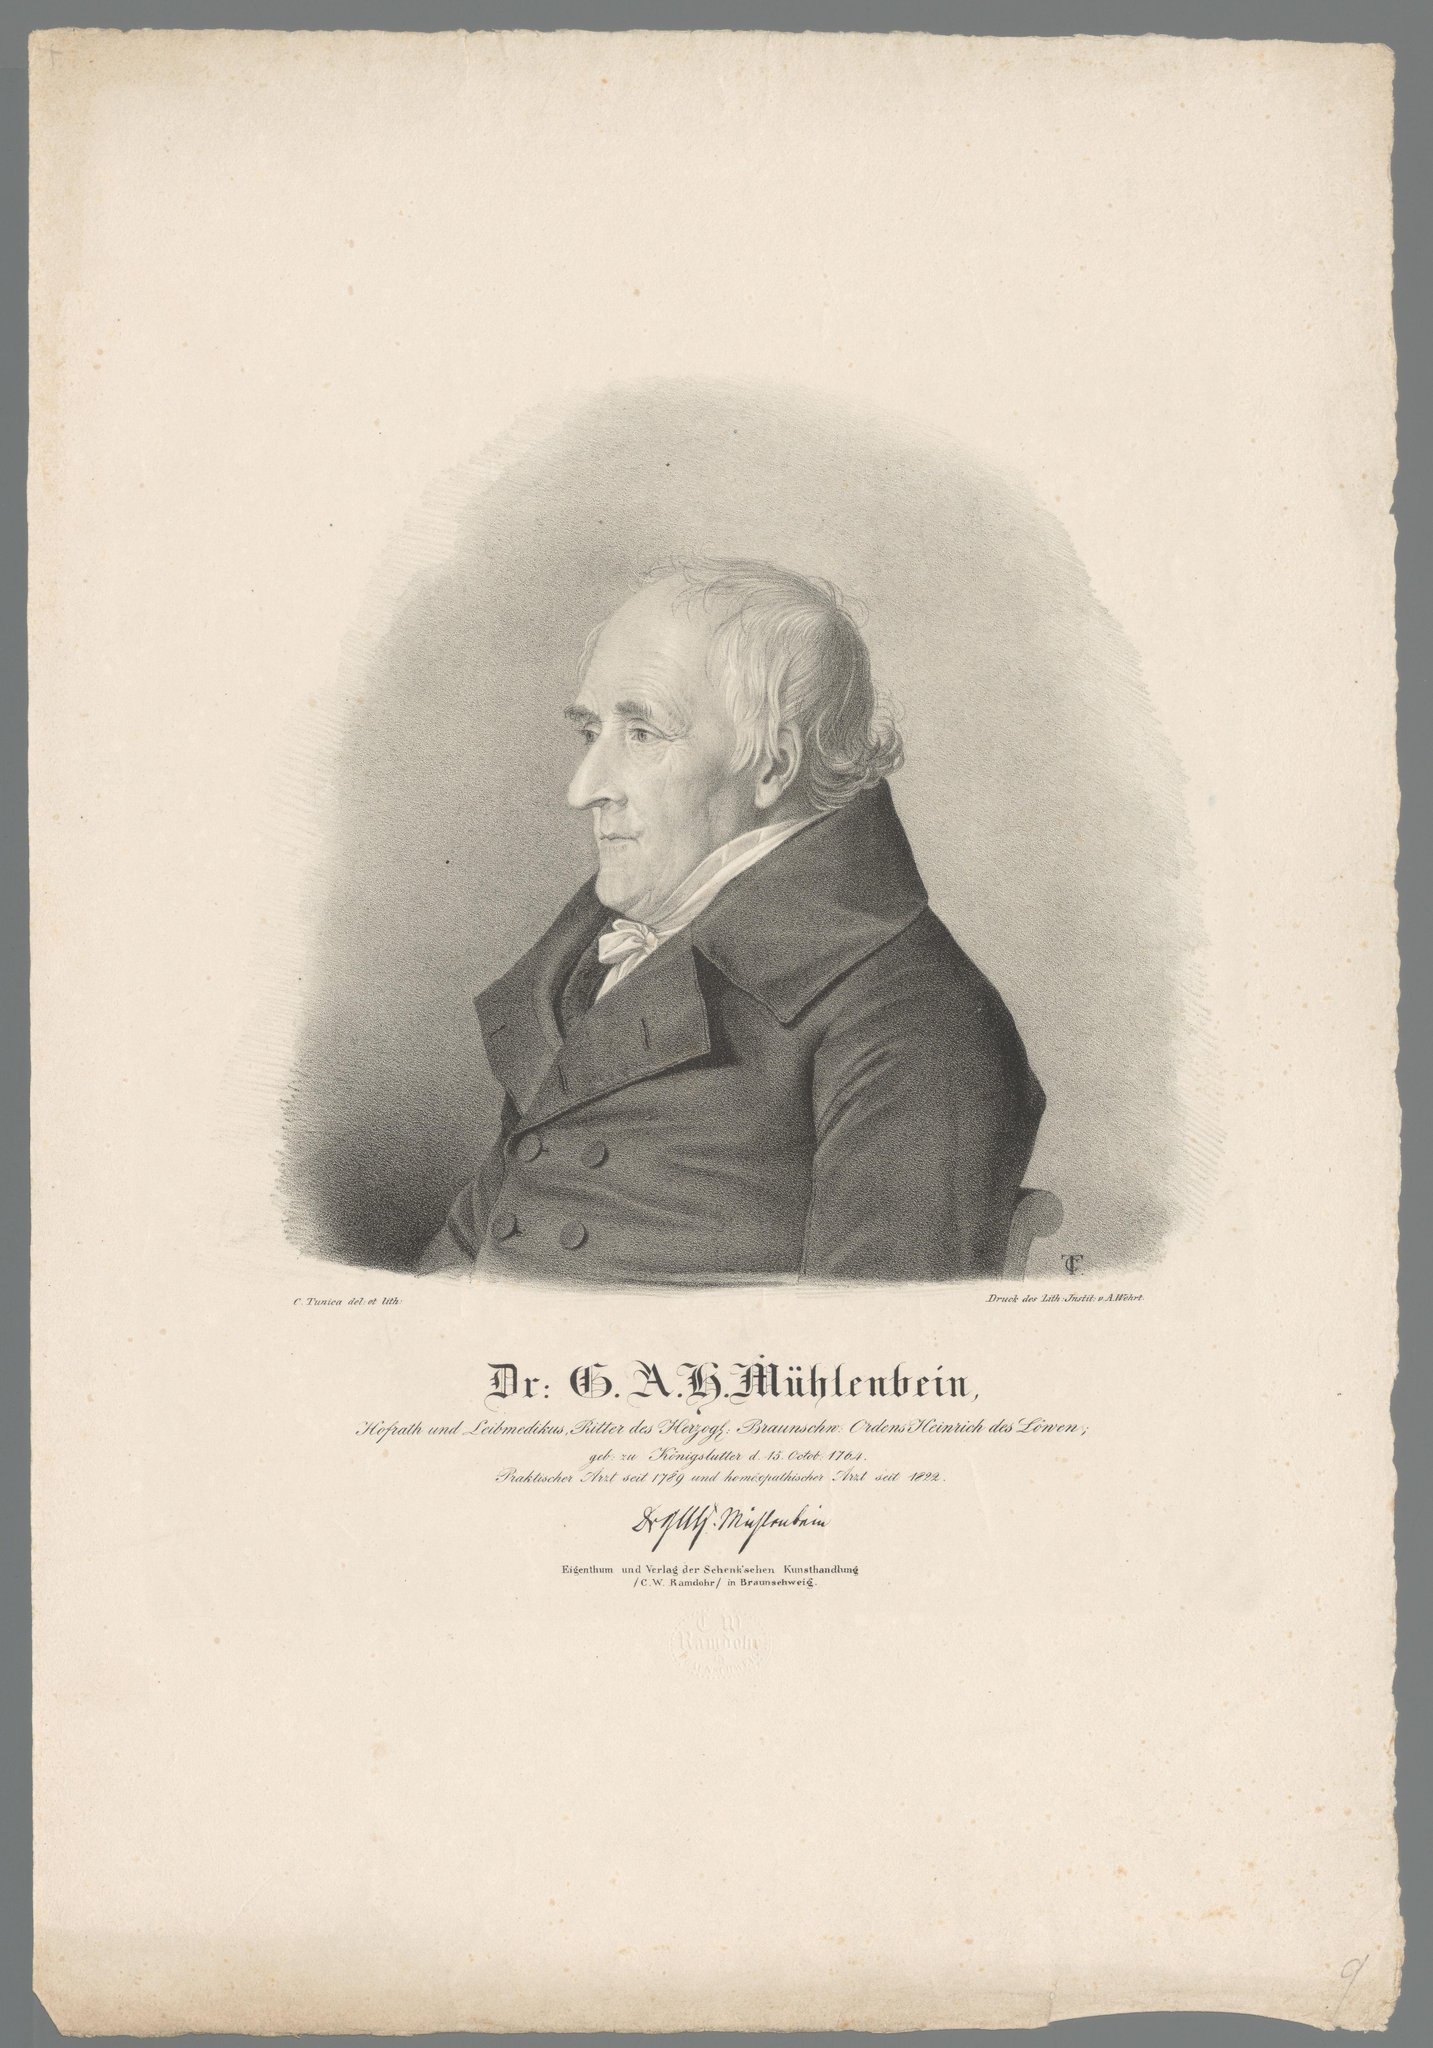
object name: print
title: Dr. G.A.B. Mühlenbein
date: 1822-1868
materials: paper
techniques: lithograph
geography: braunschweig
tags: adult man, historical persons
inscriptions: collector's mark: Lugt 2228, mark: Lugt 2129